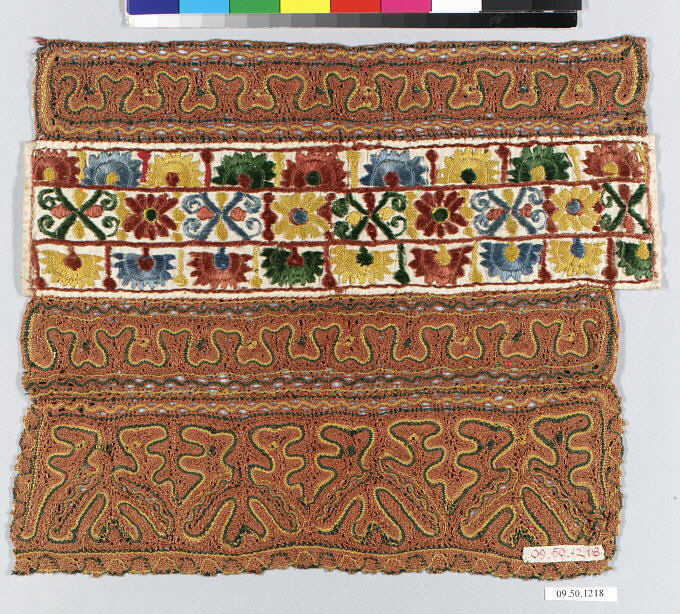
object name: headdress part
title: Detail from a headdress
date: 1801-1900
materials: thread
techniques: lace